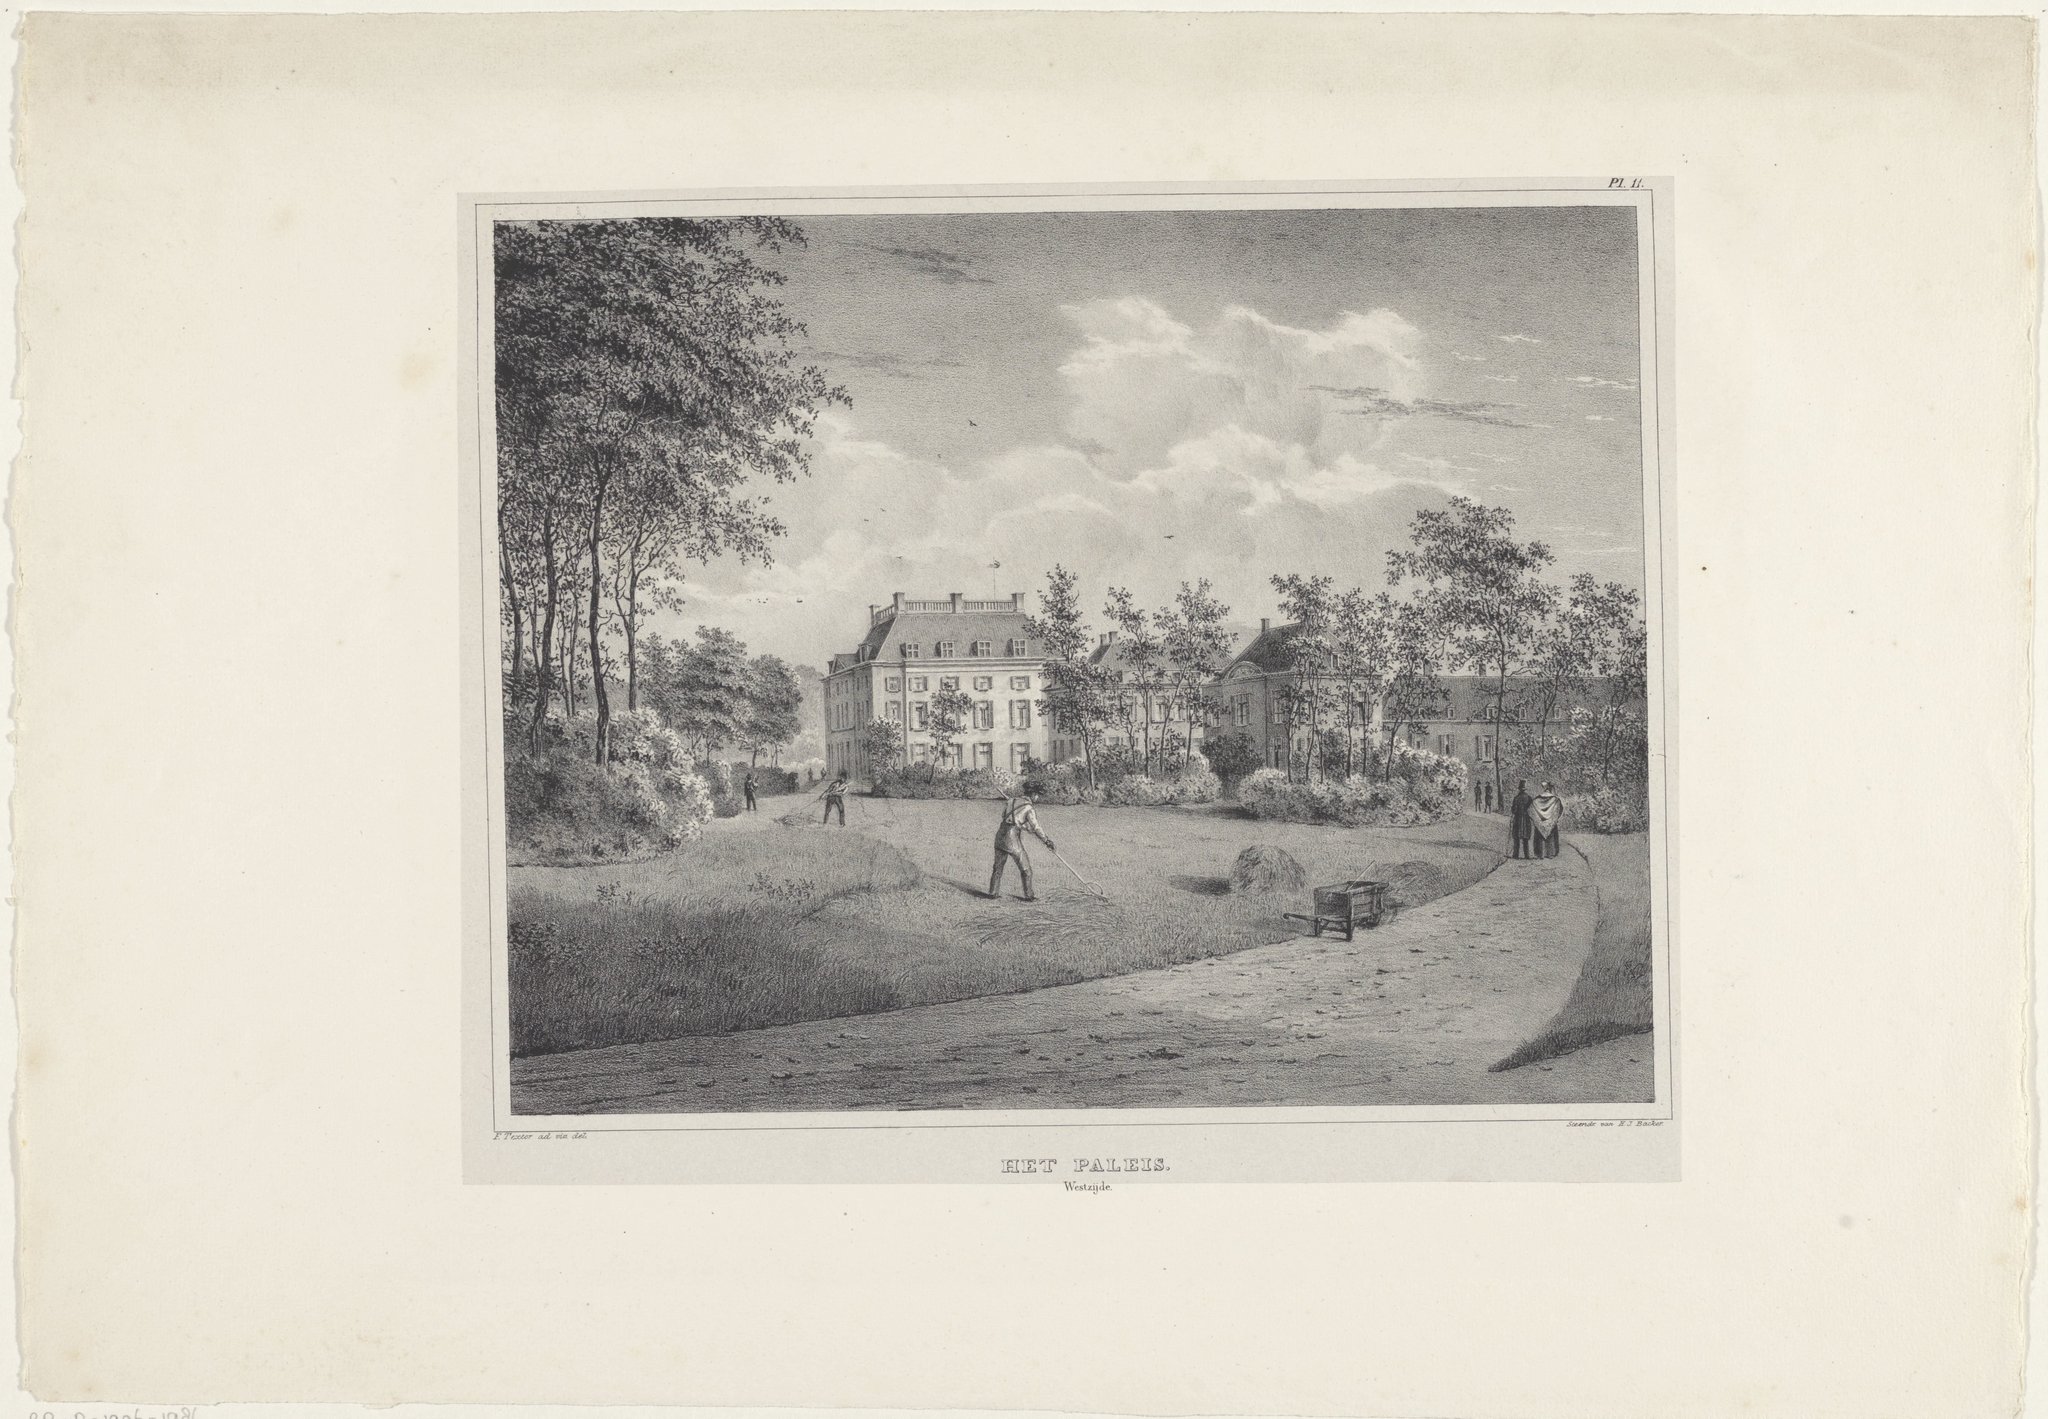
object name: print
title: Westzijde van Paleis Het Loo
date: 1822-1845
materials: paper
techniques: lithograph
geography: the hague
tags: park, strolling, palace, lawn, reaping, picking, mowing ~ harvest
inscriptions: collector's mark: Lugt 2228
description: Tuinmannen maaien het gras voor het paleis. Op de weg lopen wandelaars. Genummerd rechtsboven: Pl. 11.